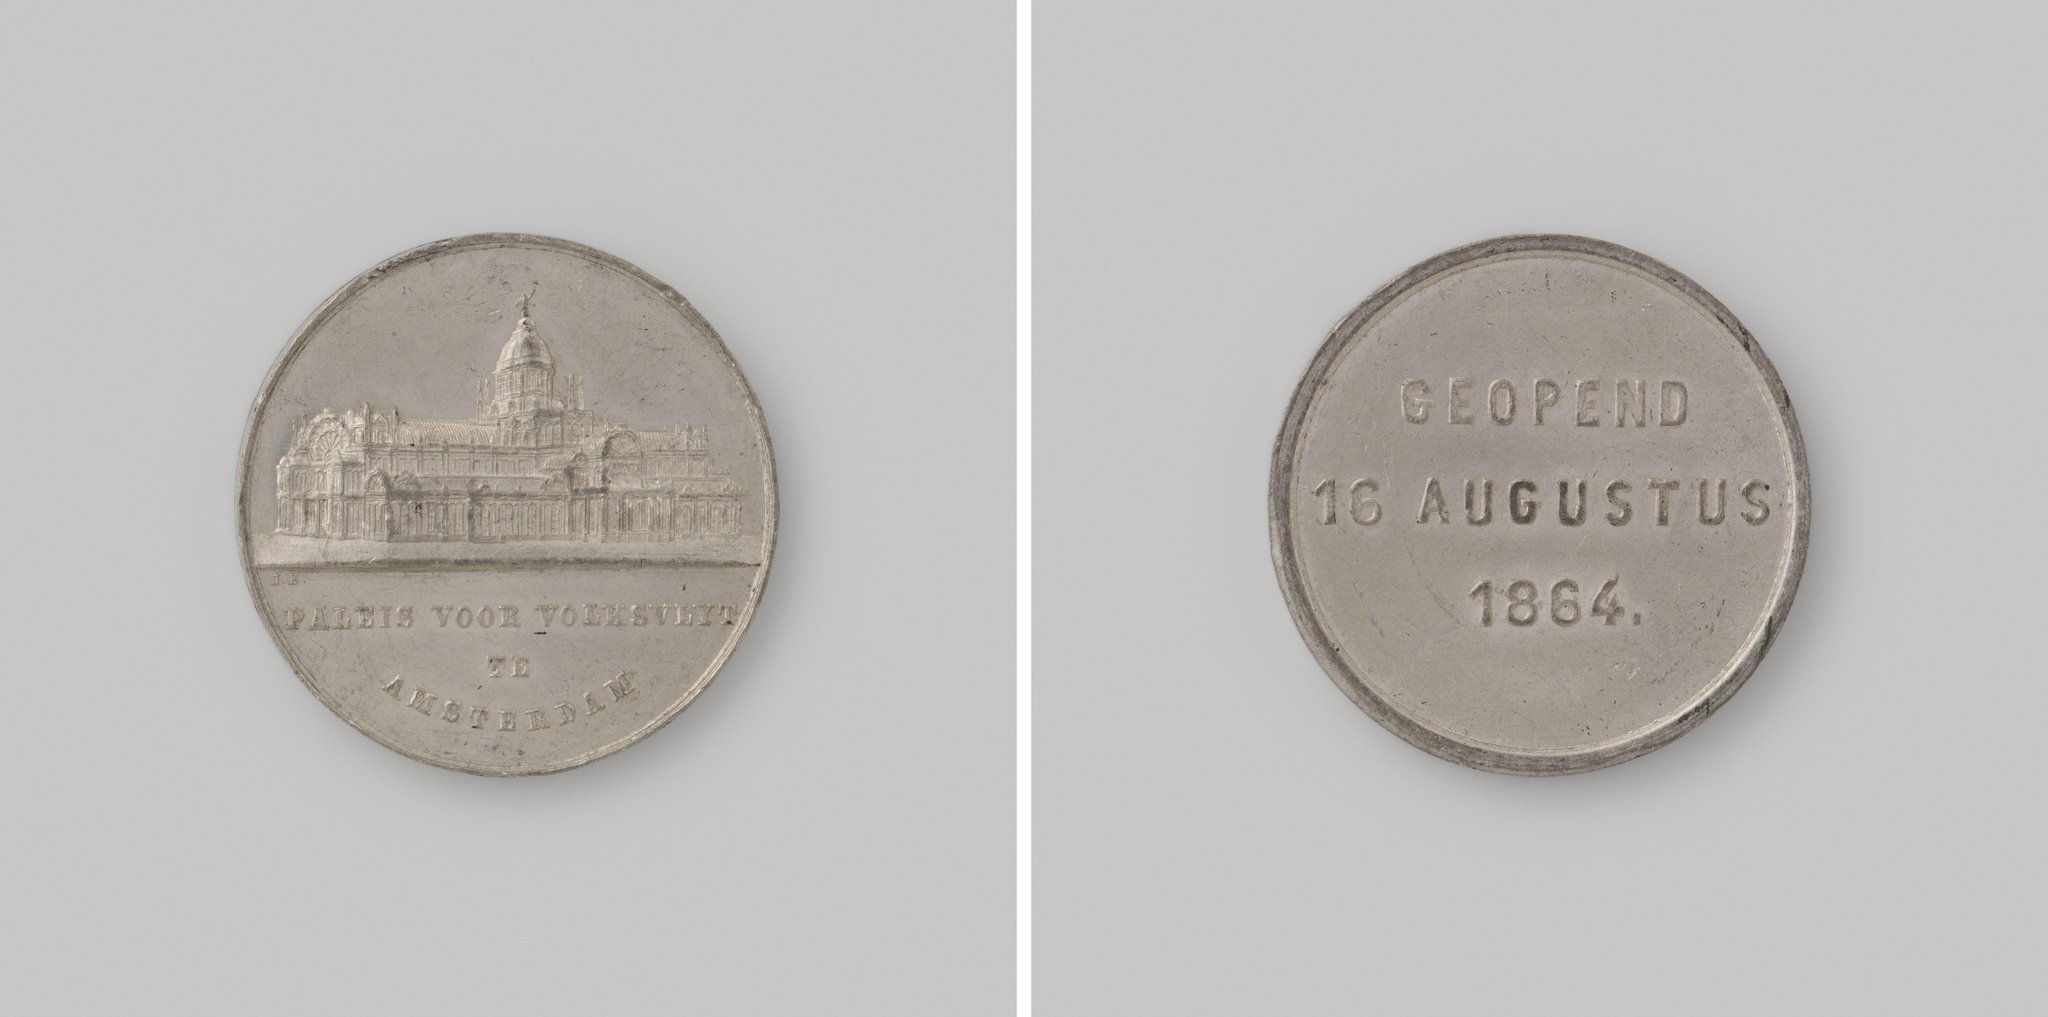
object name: history medal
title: Opening van het Paleis voor Volksvlijt te Amsterdam 1864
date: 1864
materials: tin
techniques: striking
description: Tinnen penning, op de voorzijde het aanzicht van het Paleis met afsnedetekst, op de keerzijde drie regels tekst.